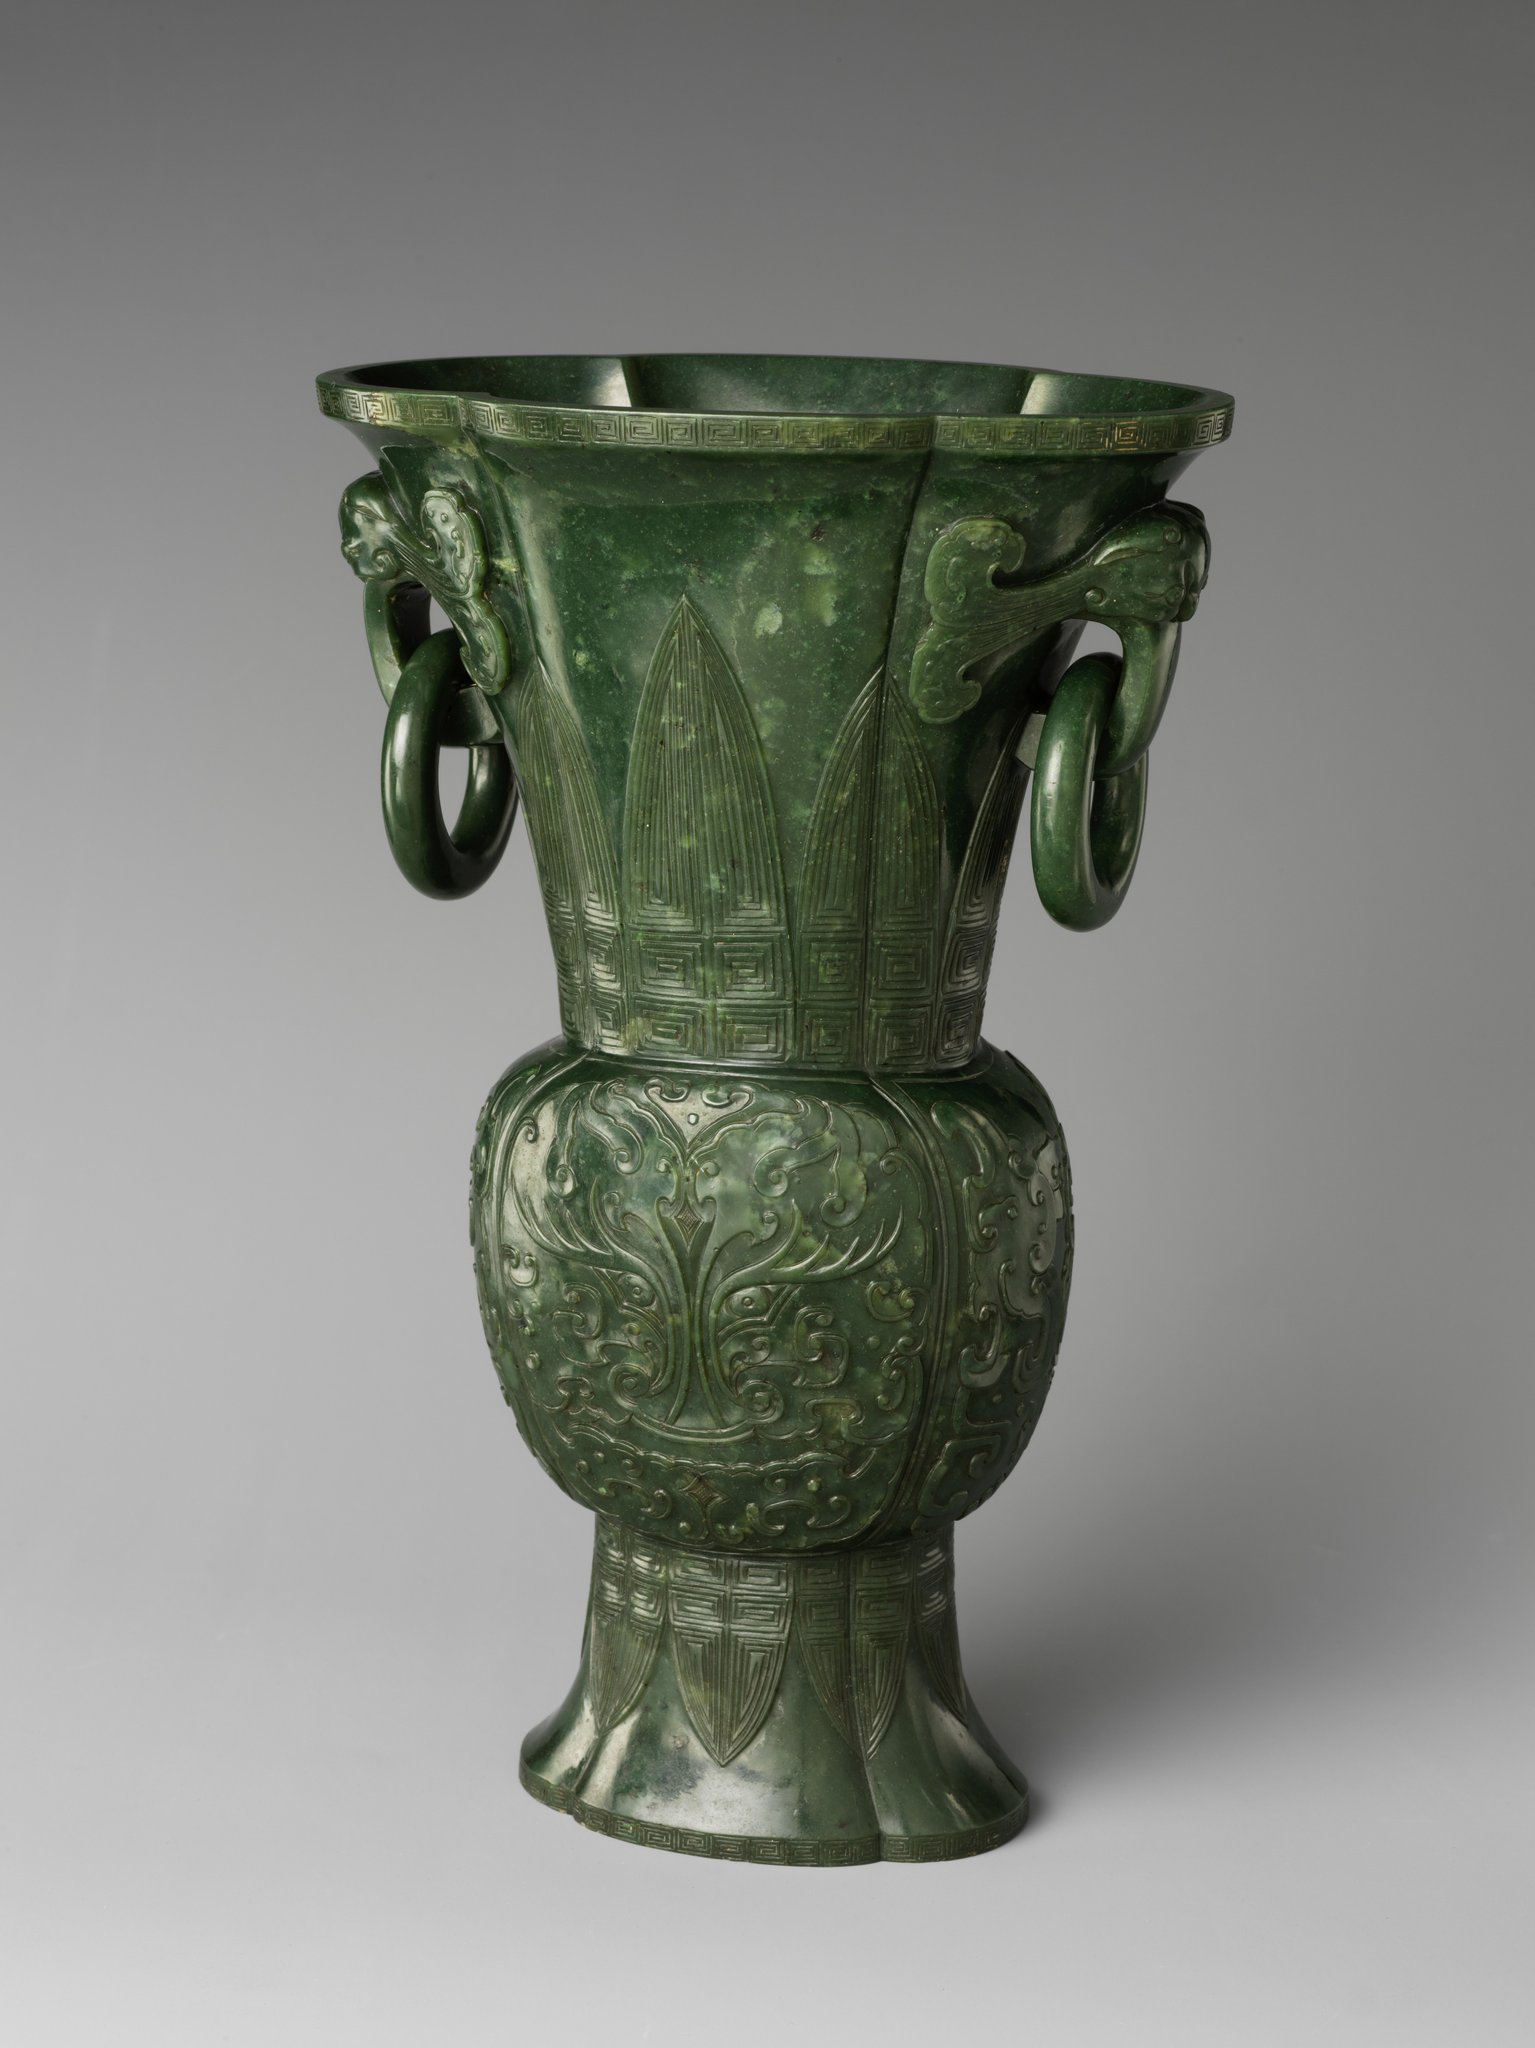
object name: vase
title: Archaic-style vase with ring handles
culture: chinese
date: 1736-1795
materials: jade